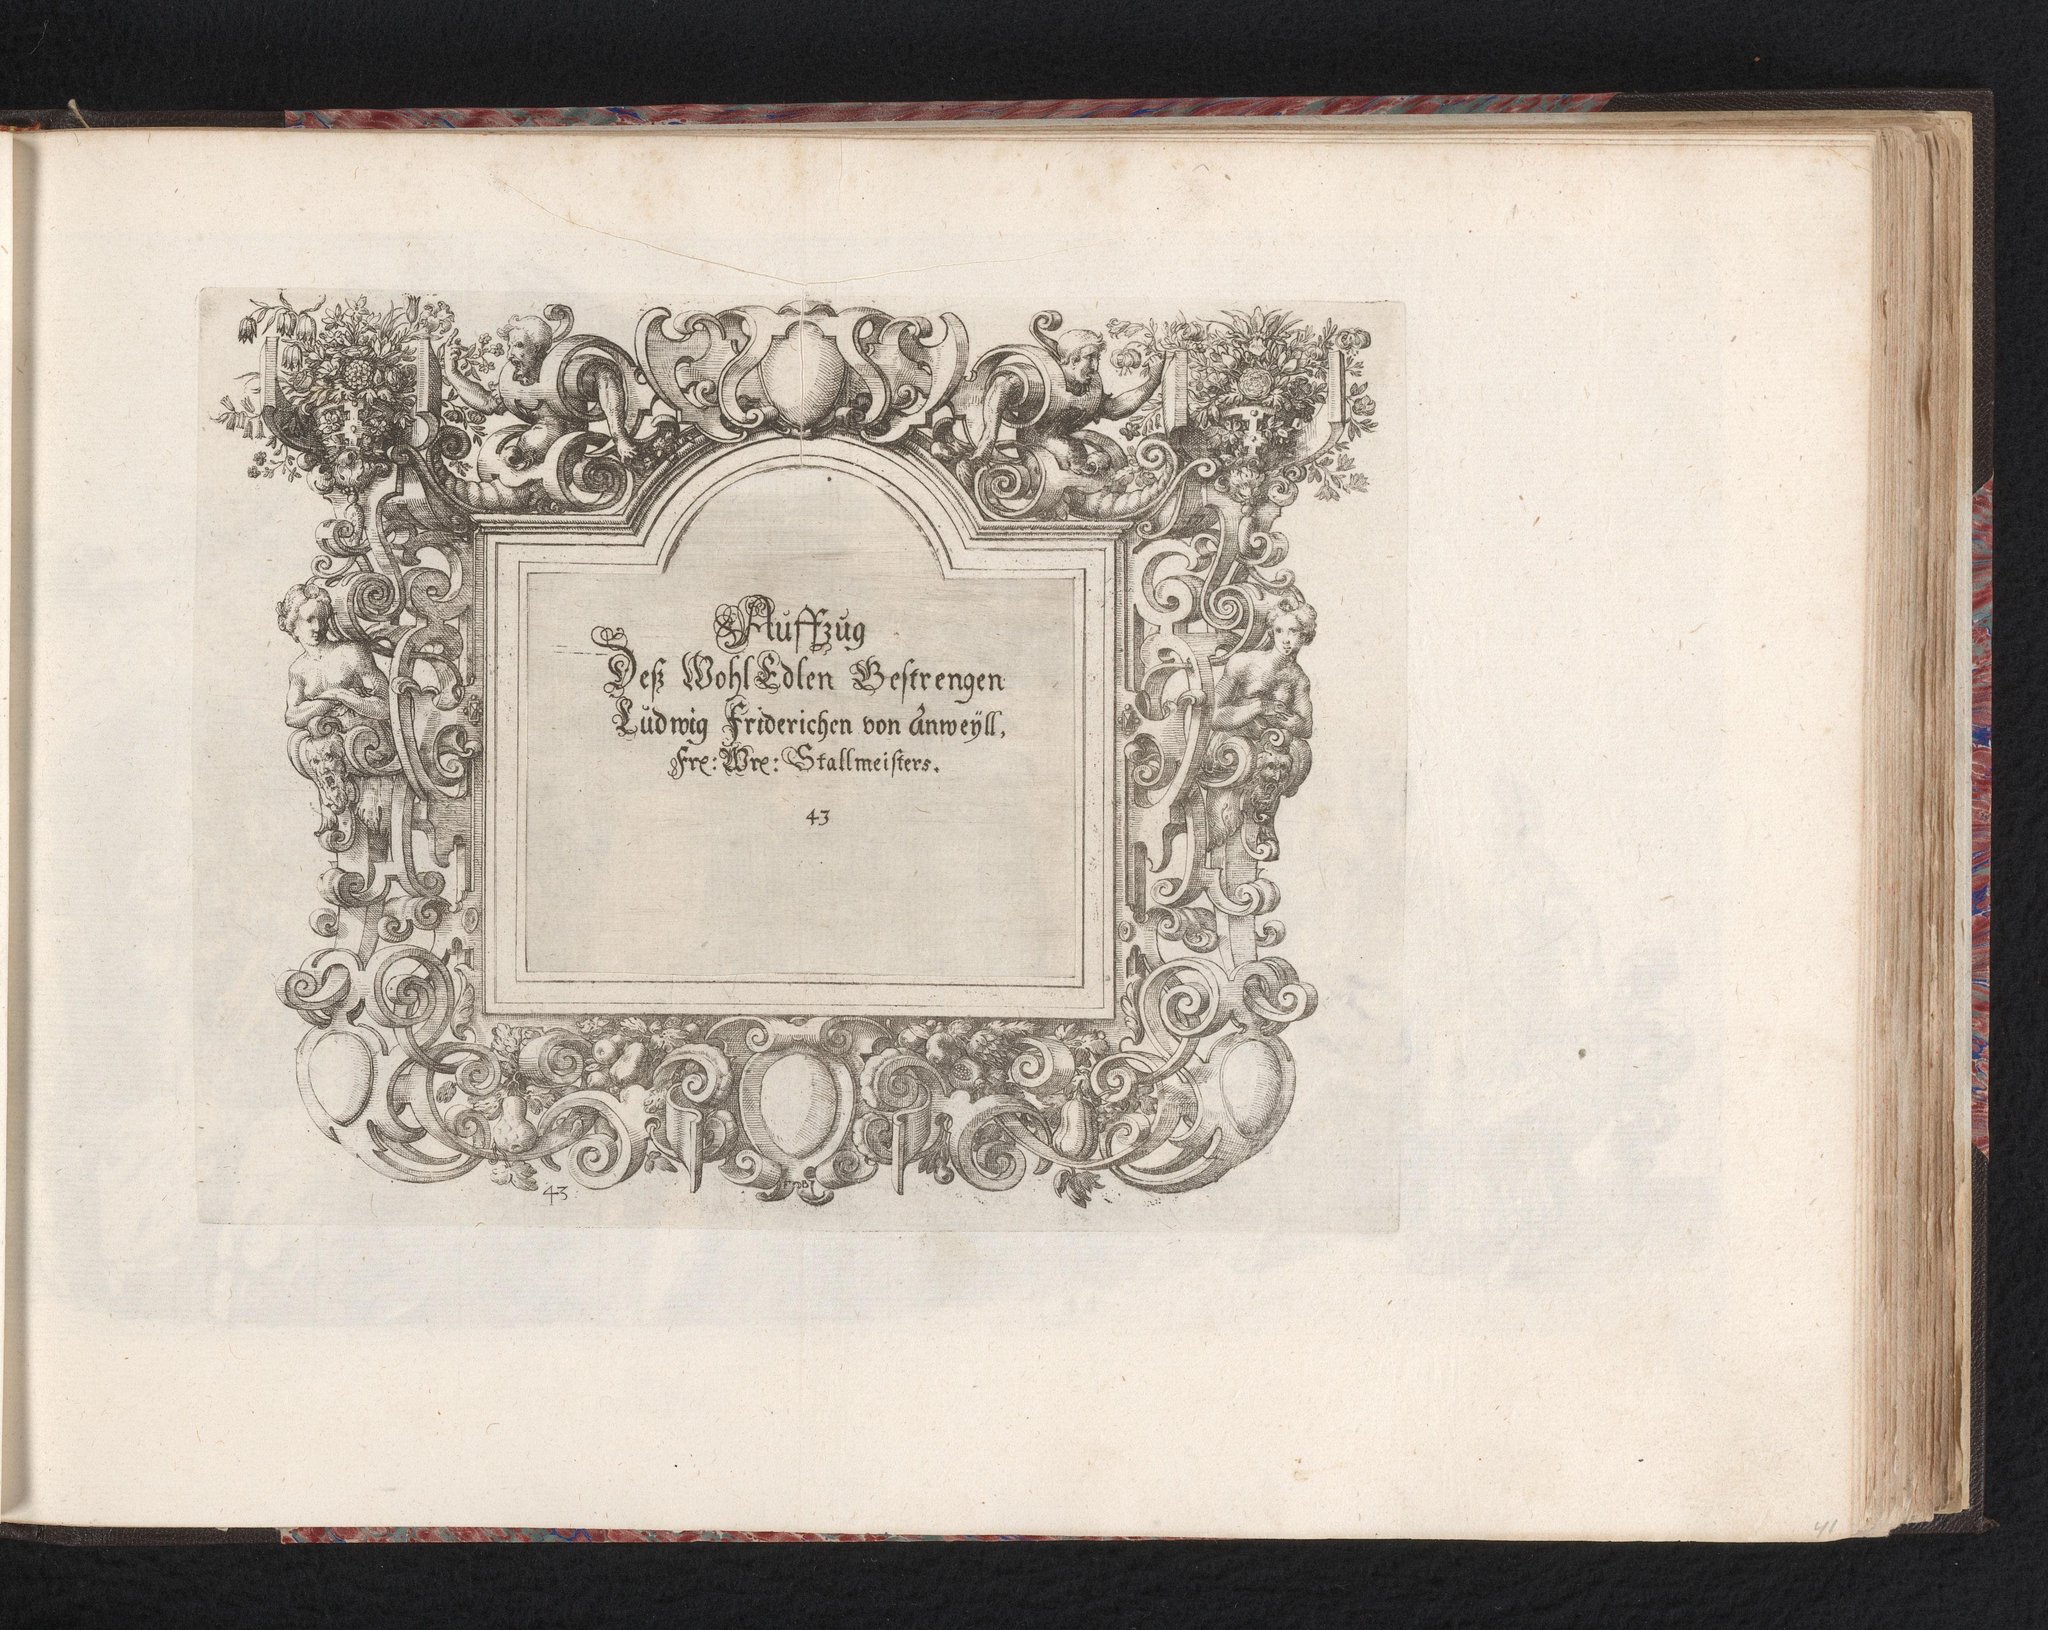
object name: print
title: Aigentliche wahrhaffte Delineation unnd Abbildung aller fürstlichen Auffzüg und Rütterspilen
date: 1618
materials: paper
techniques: etching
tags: eyeglasses, spectacles, performance in the open air (pleasure fair), horses (circus performance)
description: Genummerd: 42. Deze prent maakt deel uit van een album.